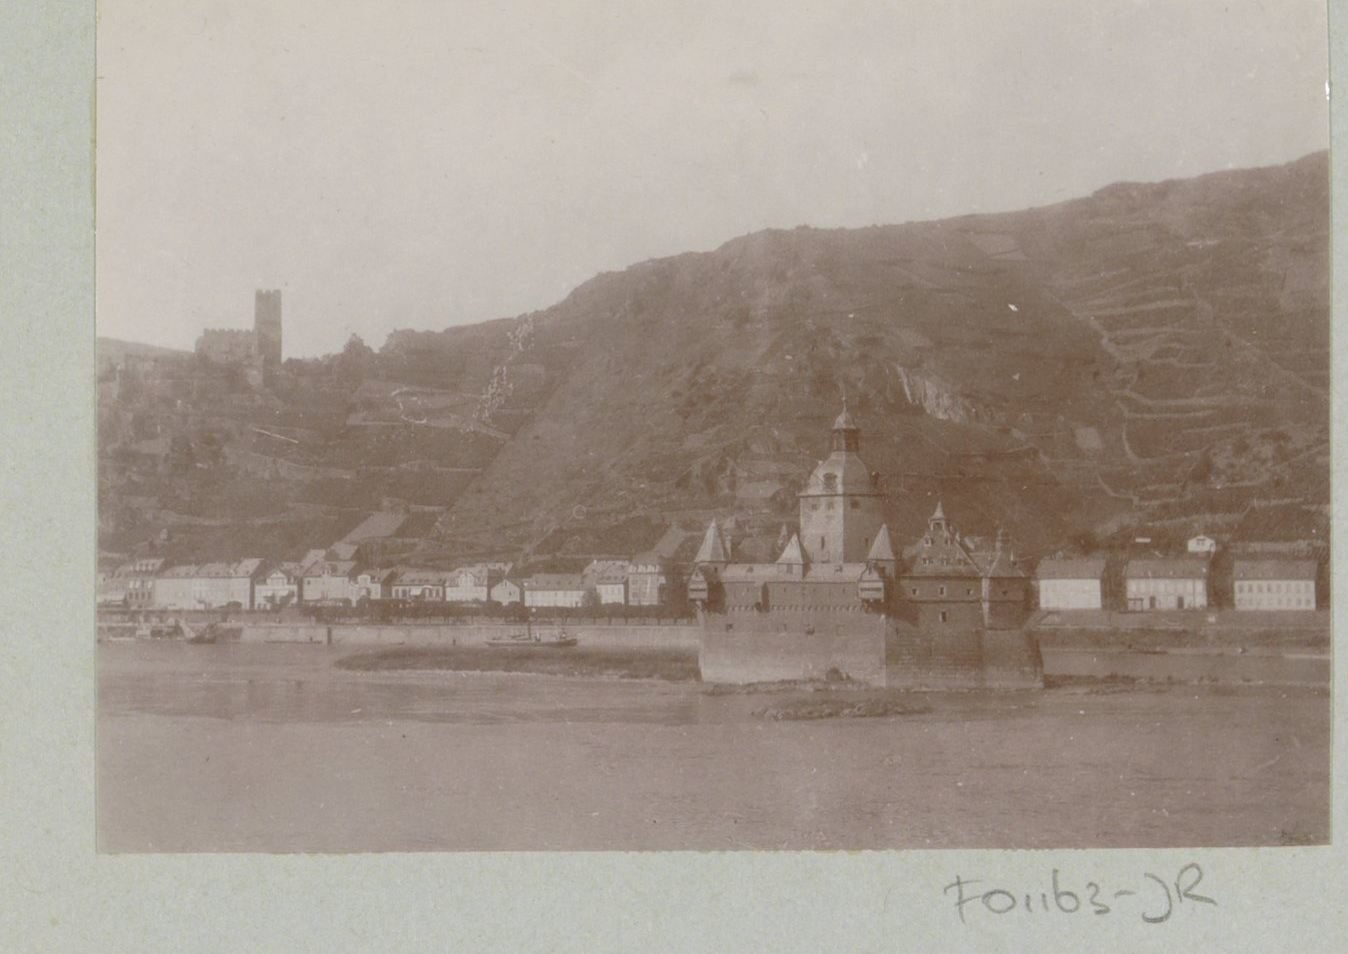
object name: photograph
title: Gezicht op Burg Pfalzgrafenstein in de Rijn bij Kaub met op de achtergrond Burg Gutenfels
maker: delizy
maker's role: manufacturer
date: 1900-1906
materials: paper, photographic support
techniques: gelatin silver print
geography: kaub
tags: prospect of village, silhouette of village, dale, valley, castle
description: Onderdeel van Fotoalbum van een Franse amateurfotograaf met opnames van uitstapjes in Frankrijk, Spanje, België, Luxemburg en Nederland, de eerste automobielen en autoraces.